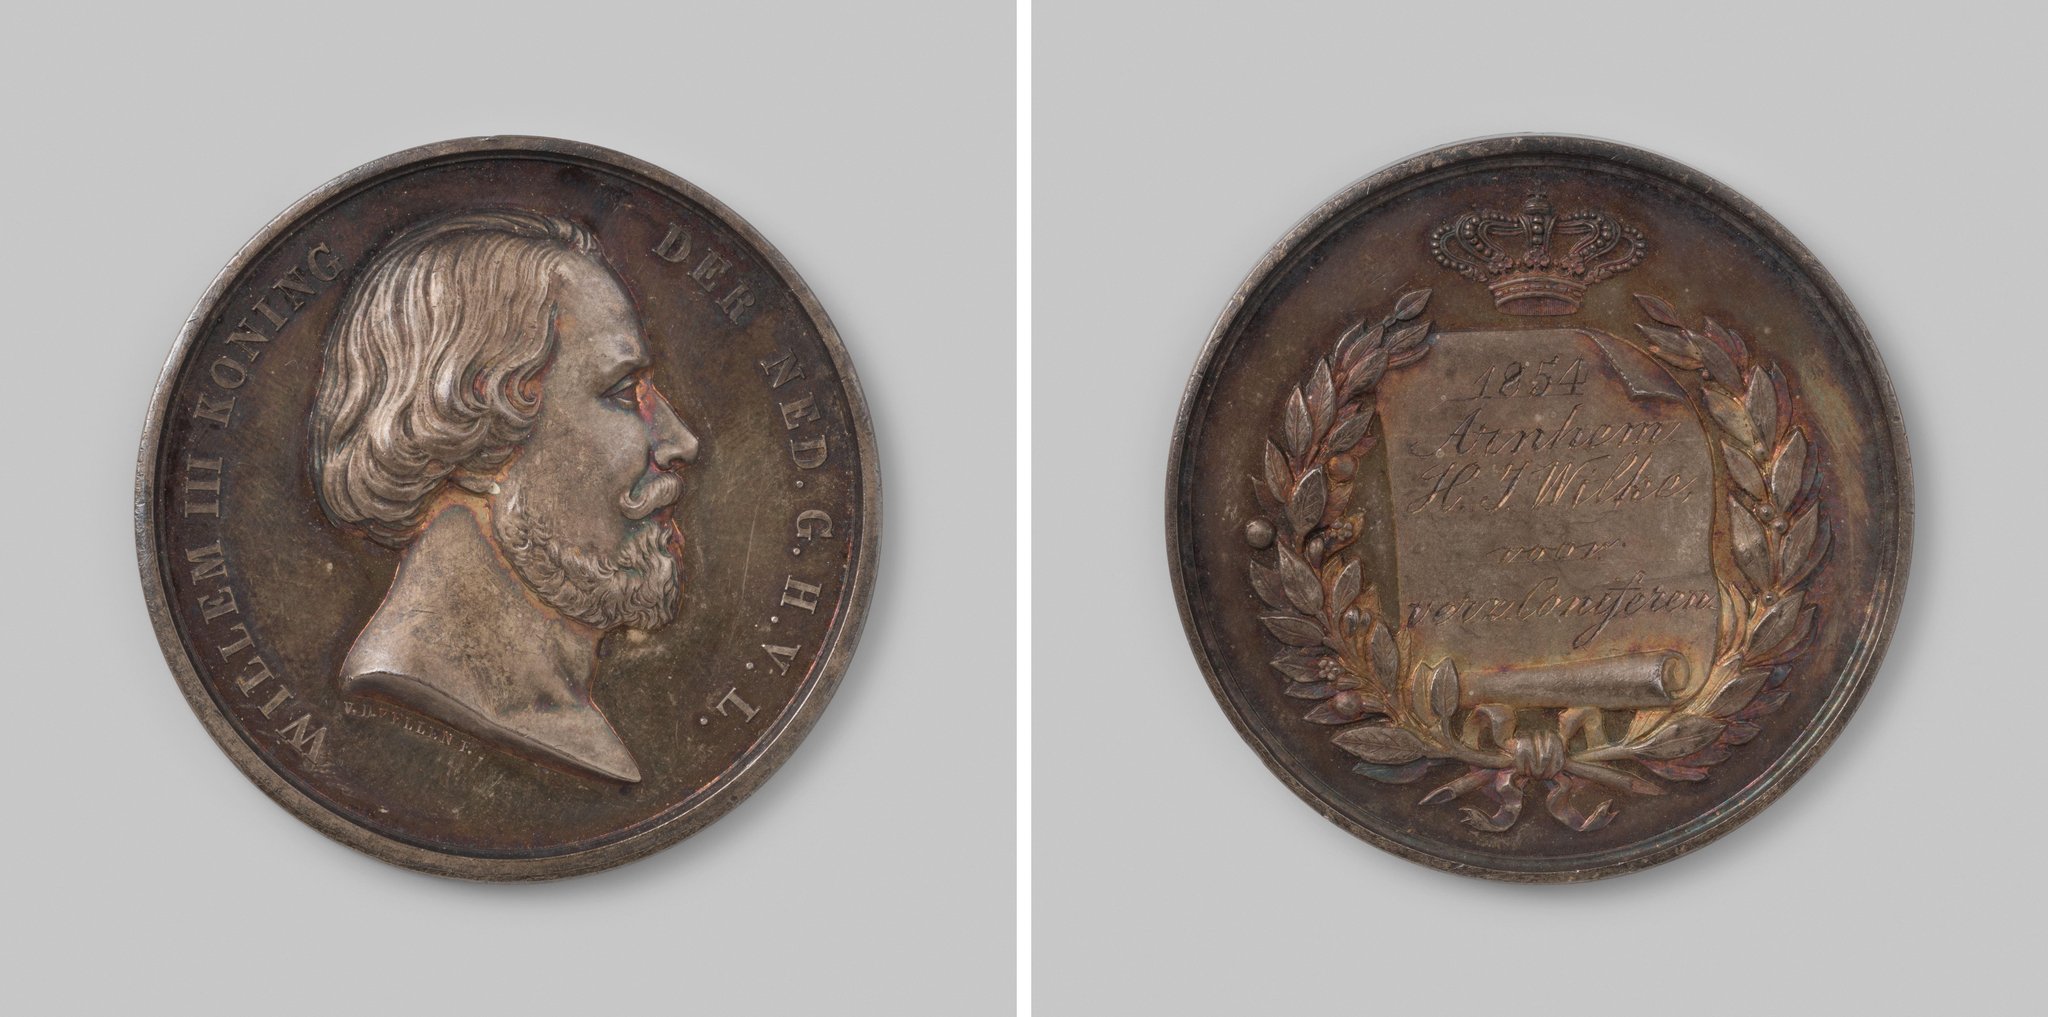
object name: medal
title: Tentoonstelling van land- en tuinbouw te Arnhem, ter ere van Willem III, koning der Nederlanden, penning uitegereikt aan H.J. Wilke voor zijn coniferen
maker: david van der kellen (1804-1879)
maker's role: die cutter, draughtsman, print maker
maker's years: 1804-1879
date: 1854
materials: silver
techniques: engraving, striking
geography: utrecht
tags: brussels, willem iii (koning der nederlanden), arnhem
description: Zilveren penning. Voorzijde: borststuk man binnen omschrift. Keerzijde: rol perkament met opschrift binnen tot krans samengebonden oranje- en lauwertak onder kroon.